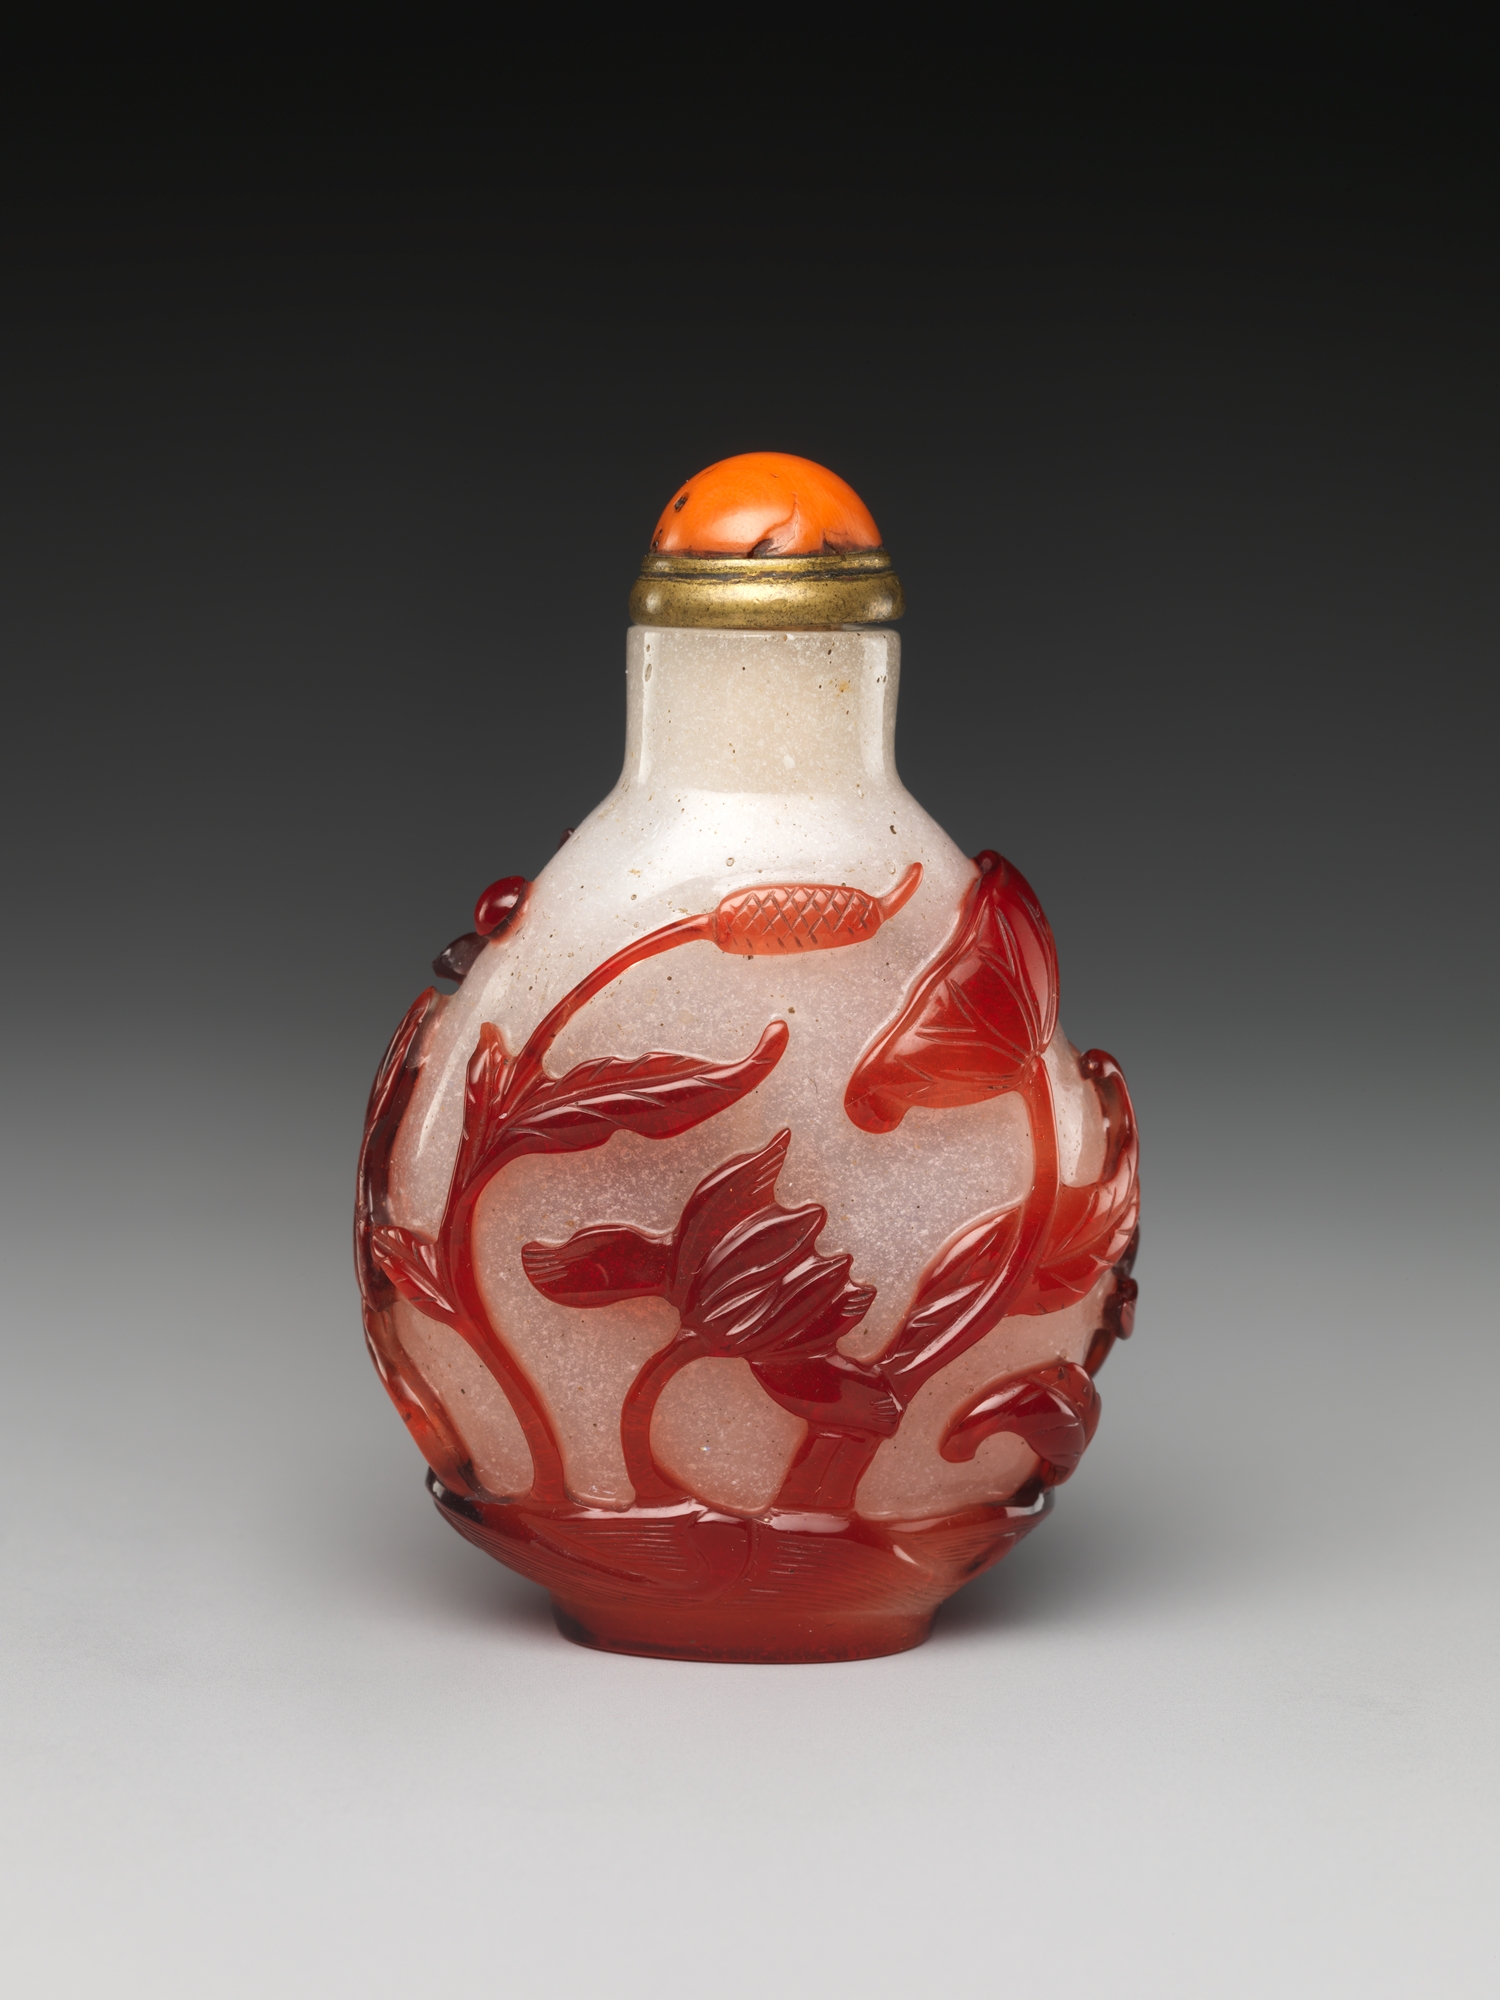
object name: snuff bottle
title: Snuff bottle with scene of a lotus pond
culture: chinese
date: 1767-1833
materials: coral, glass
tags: lotuses